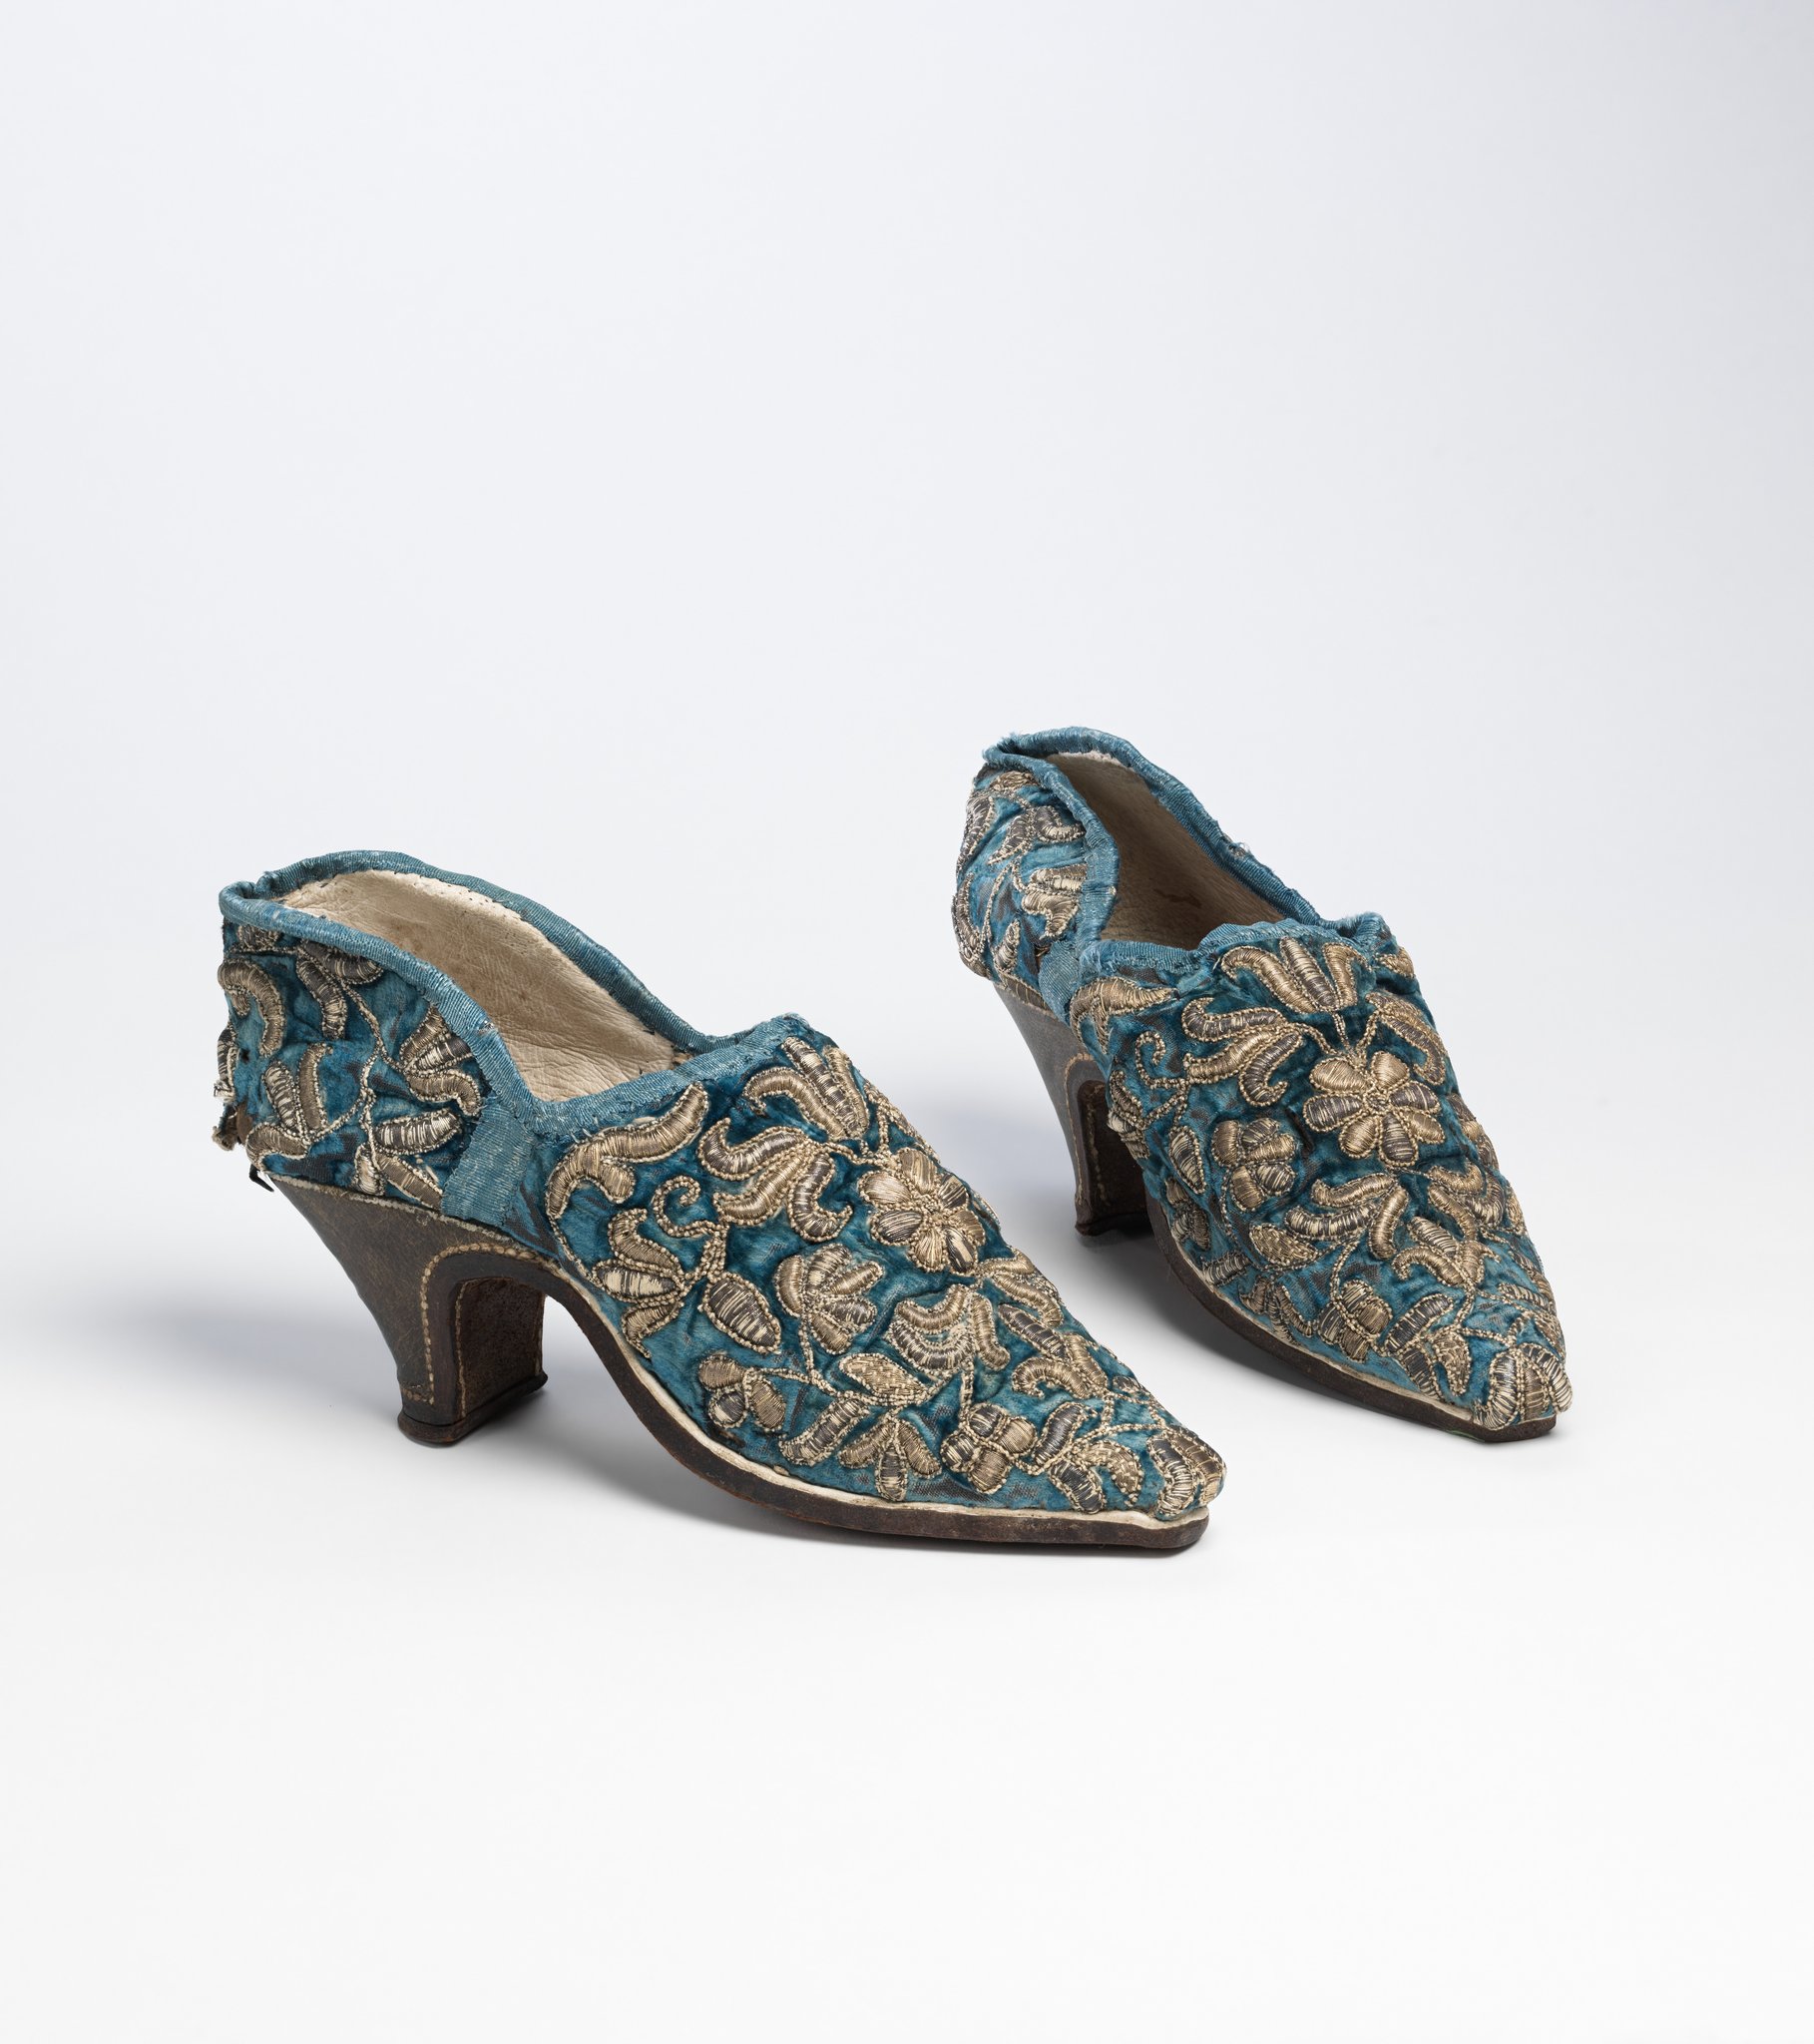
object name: shoe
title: Shoes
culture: british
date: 1650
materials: leather, metal, silk